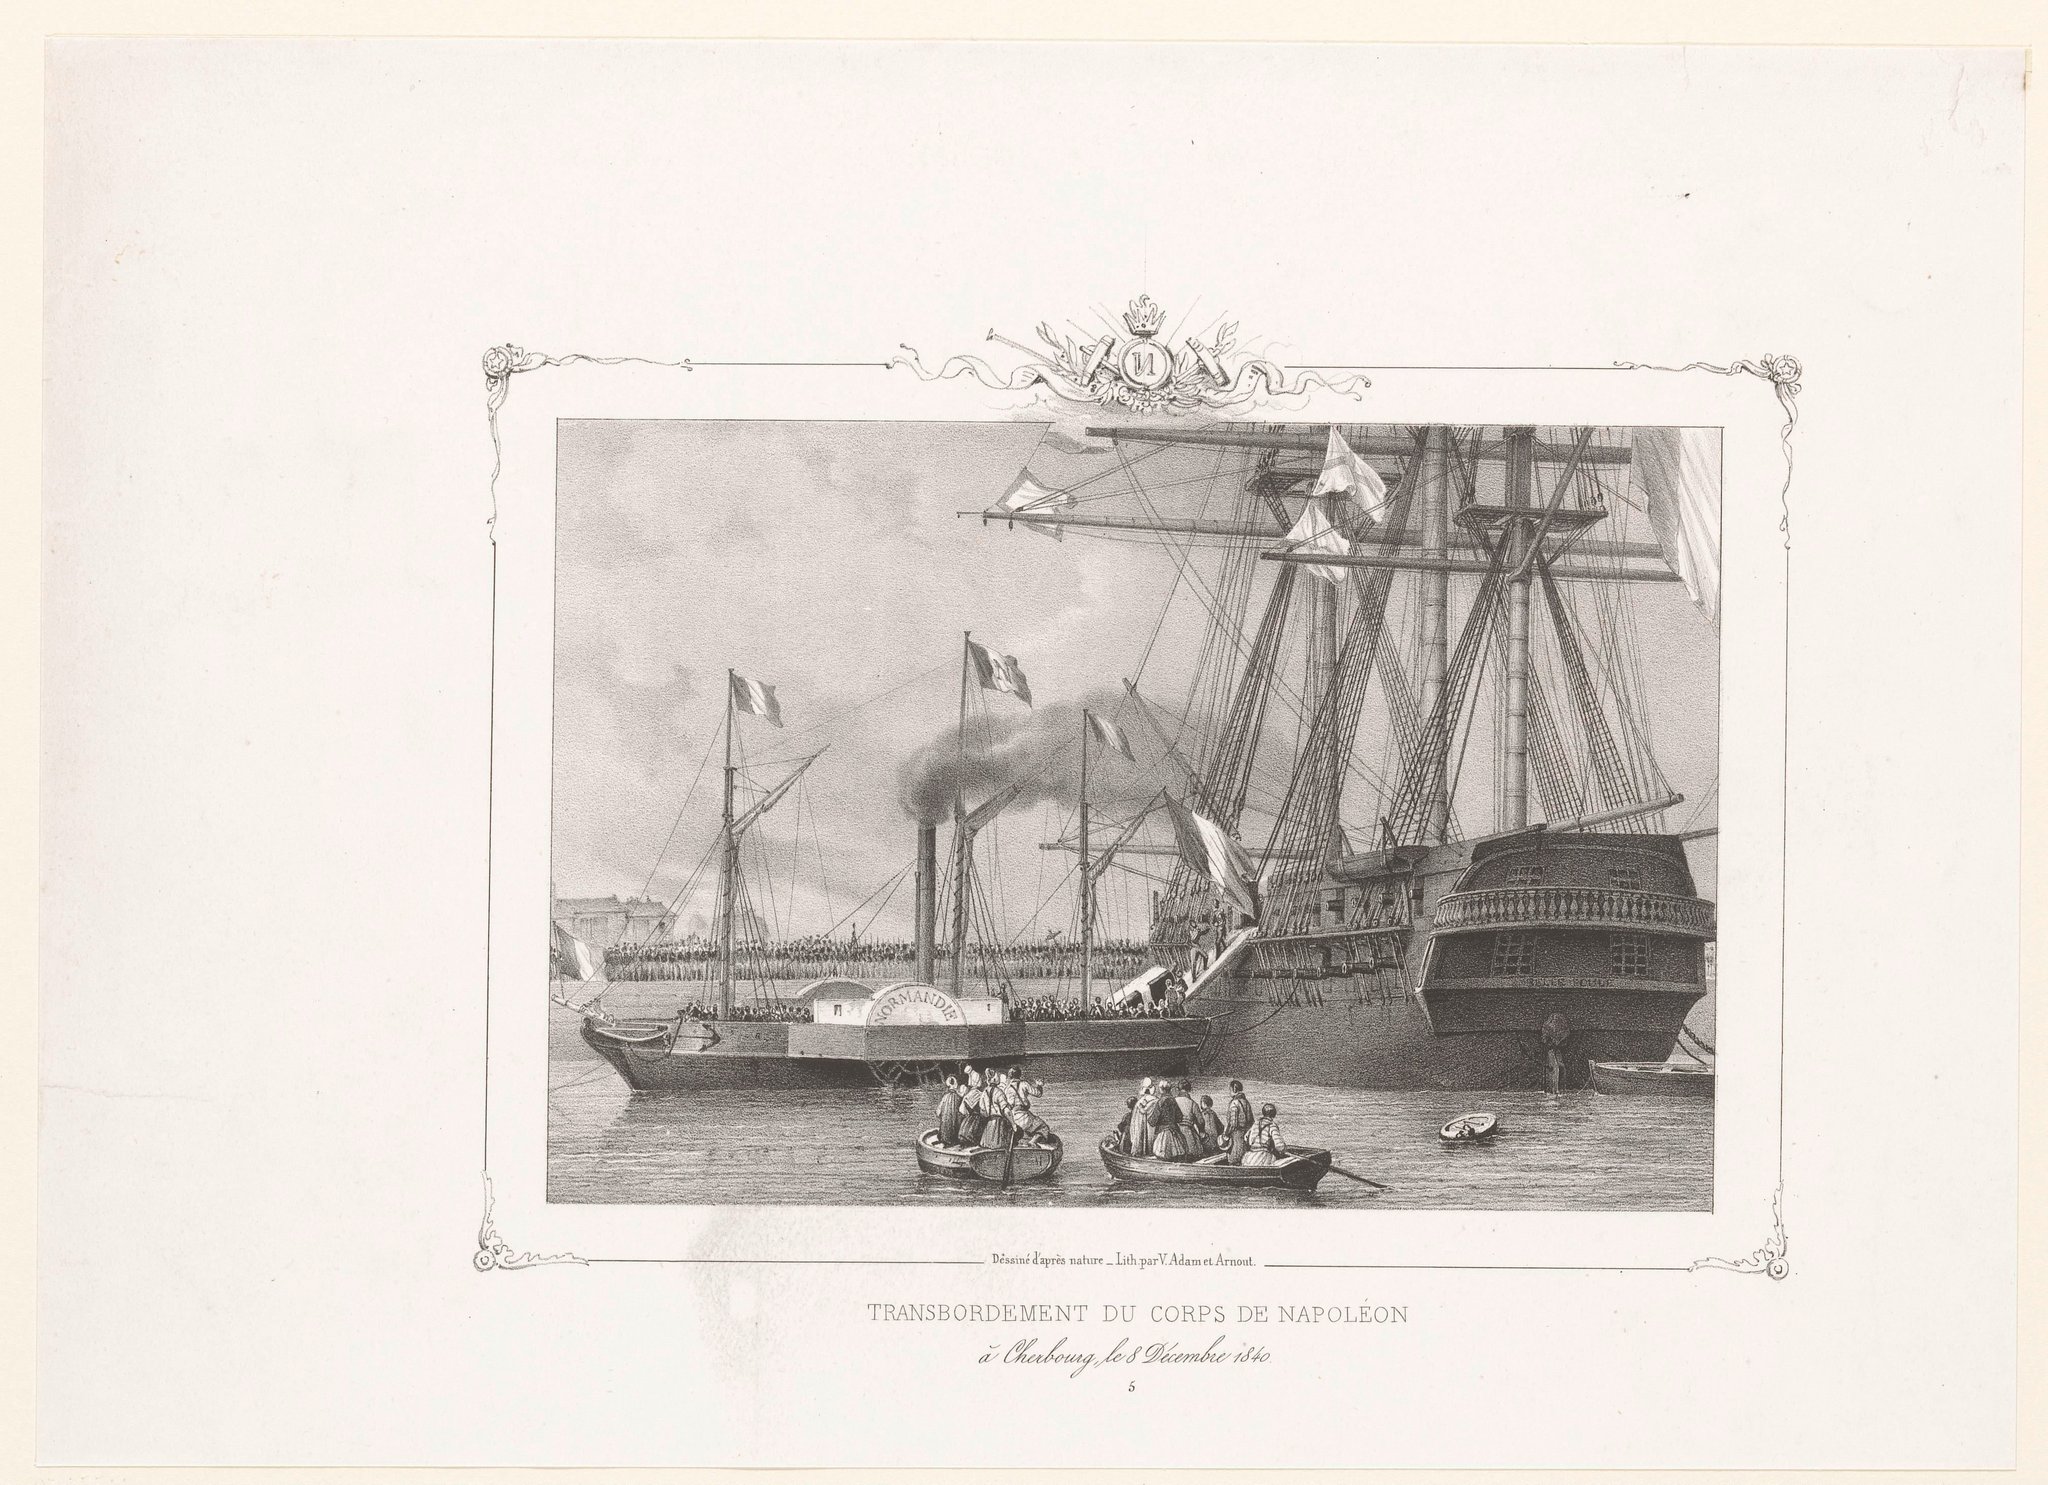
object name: print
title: Retour en France des dépouilles mortelles de Napoléon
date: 1840-1841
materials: paper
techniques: lithograph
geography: paris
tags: napoleon i (emperor of the french), re-burial, ships (in general), coffin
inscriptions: collector's mark: Lugt 2228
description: Deze serie bevat 24 prenten in klein formaat, die een vereenvoudiging zijn van eerder uitgegeven prenten in groot formaat. In 1840 werden de stoffelijke resten van Napoleon op initiatief van Adolphe Thiers en koning Louis-Philippe van Sint-Helena overgebracht naar Parijs (Le retour des cendres). De tekening voor de steendruk is naar het leven gemaakt ('dessiné d'après nature').